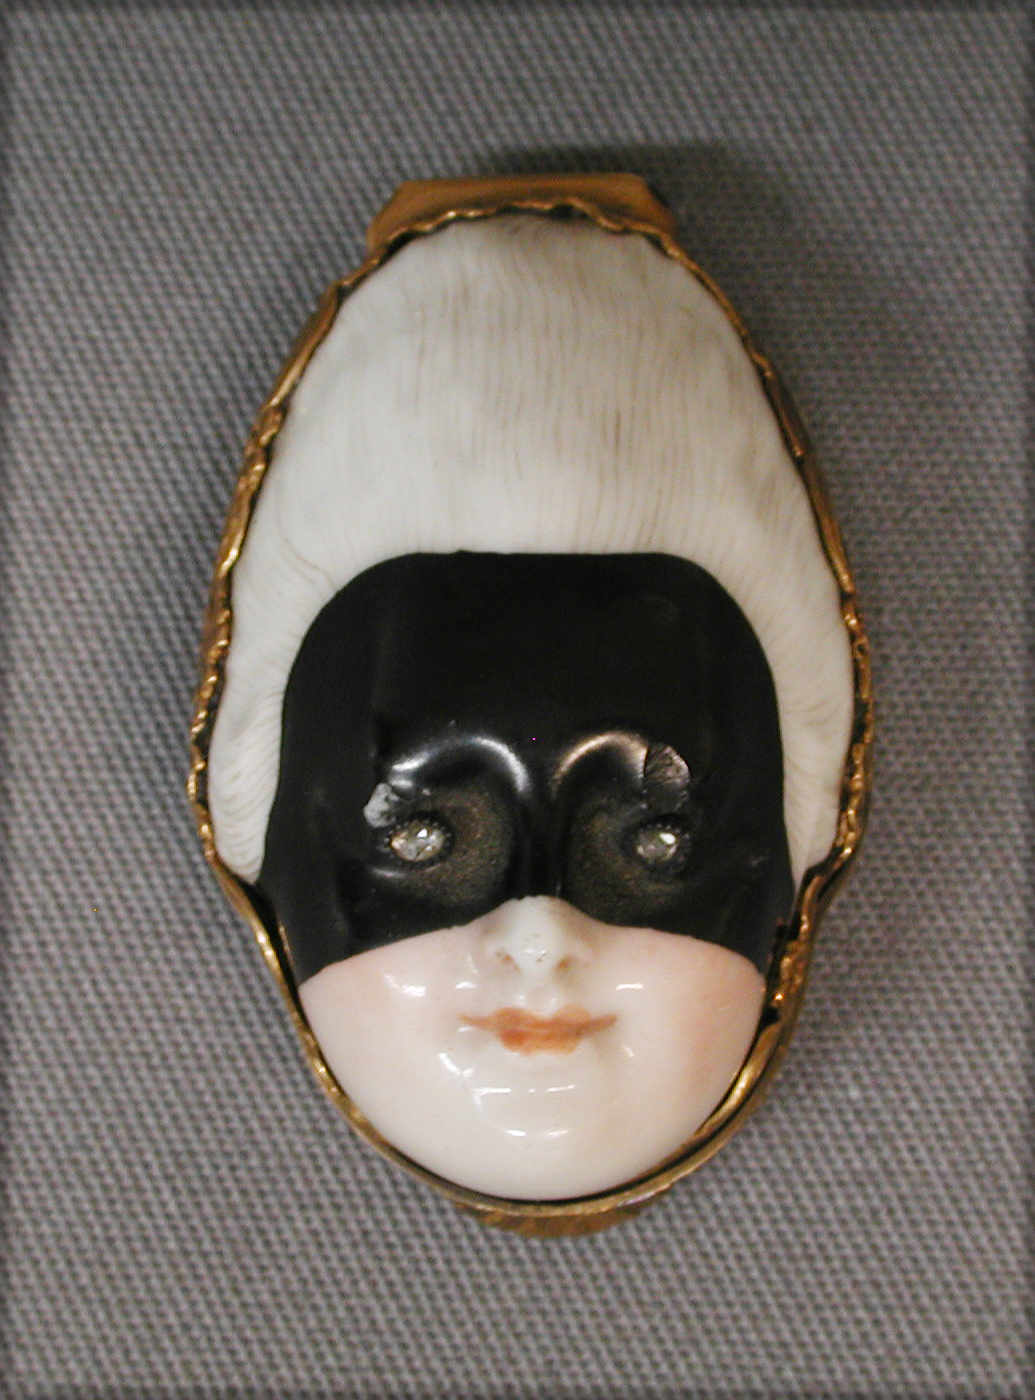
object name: patch box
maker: meissen manufactory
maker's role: manufactory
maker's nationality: german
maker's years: 1710-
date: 1750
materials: gold, hard paste porcelain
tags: faces